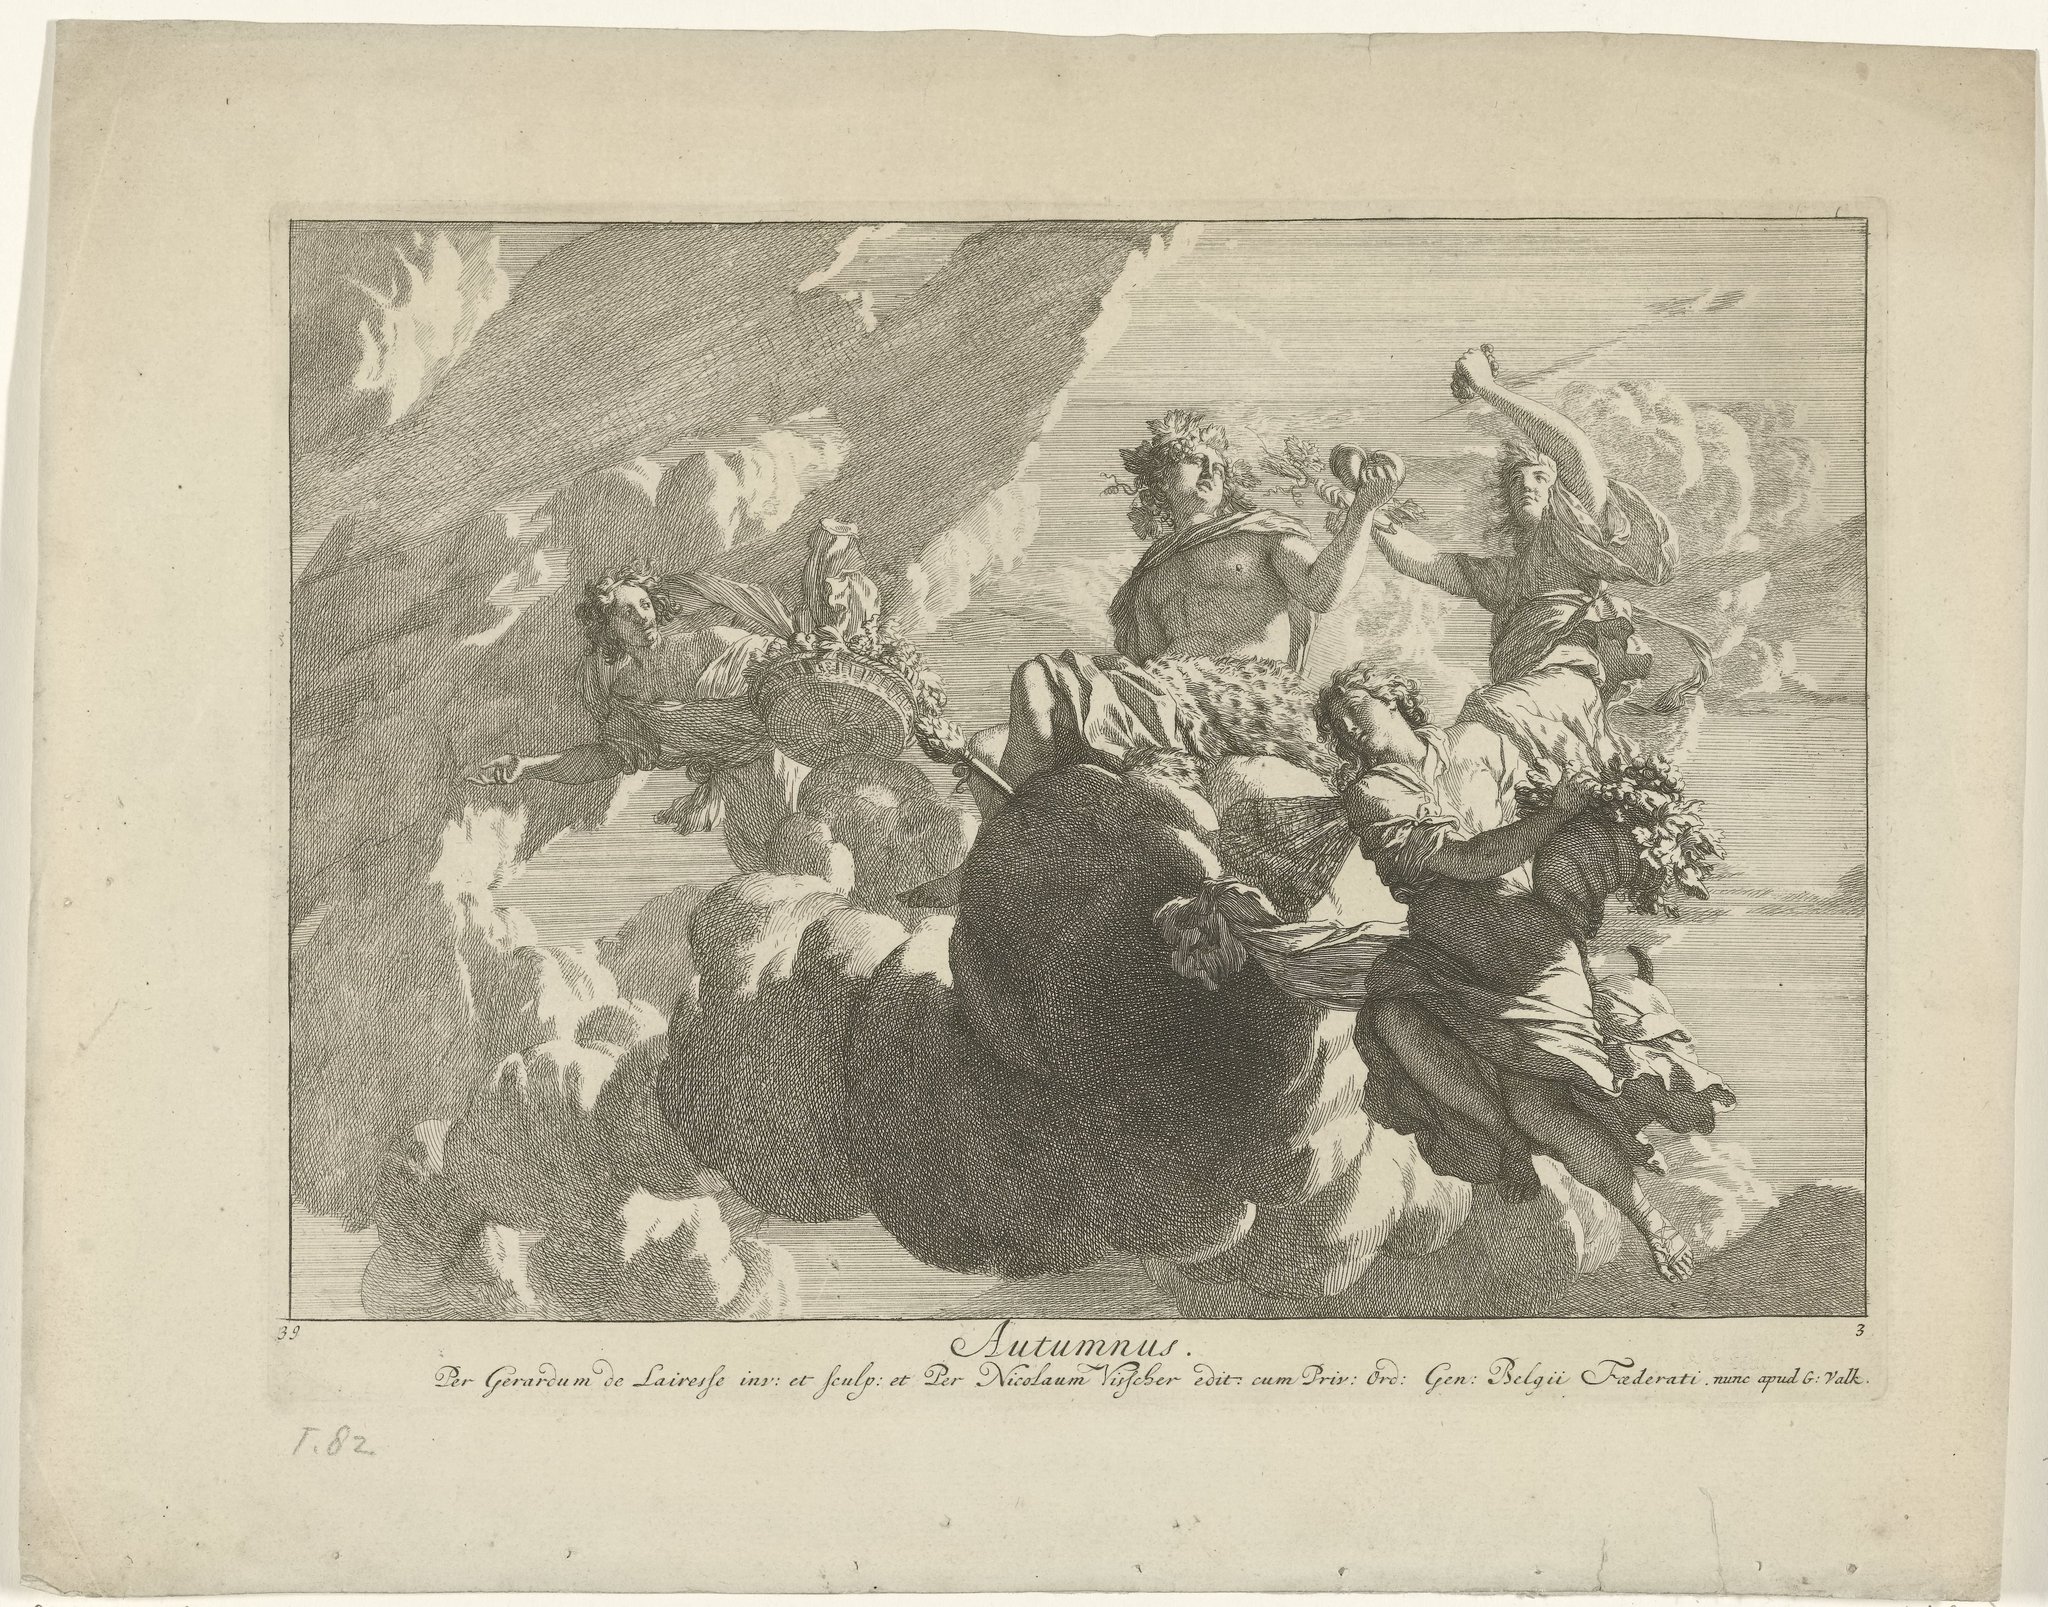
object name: print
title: De vier jaargetijden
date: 1675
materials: paper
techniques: etching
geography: amsterdam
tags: (story of) bacchus (dionysus), liber, autumn, fall, 'autumnus'; 'autunno' (ripa)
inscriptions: collector's mark: Lugt 2228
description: Bacchus zit als personificatie van de herfst op een wolk en is omgeven door drie gepersonifieerde maanden die wijnranken en ander seizoensfruit bij zich dragen. Bacchus is gedeeltelijk bedekt met een tijgervel en gekroond met wingerdbladen en druiven, in zijn linkerhand houdt hij een hoorn des overvloeds. De prent maakt deel uit van een vierdelige serie prenten over de vier jaargetijden. Links in de marge genummerd: 39.